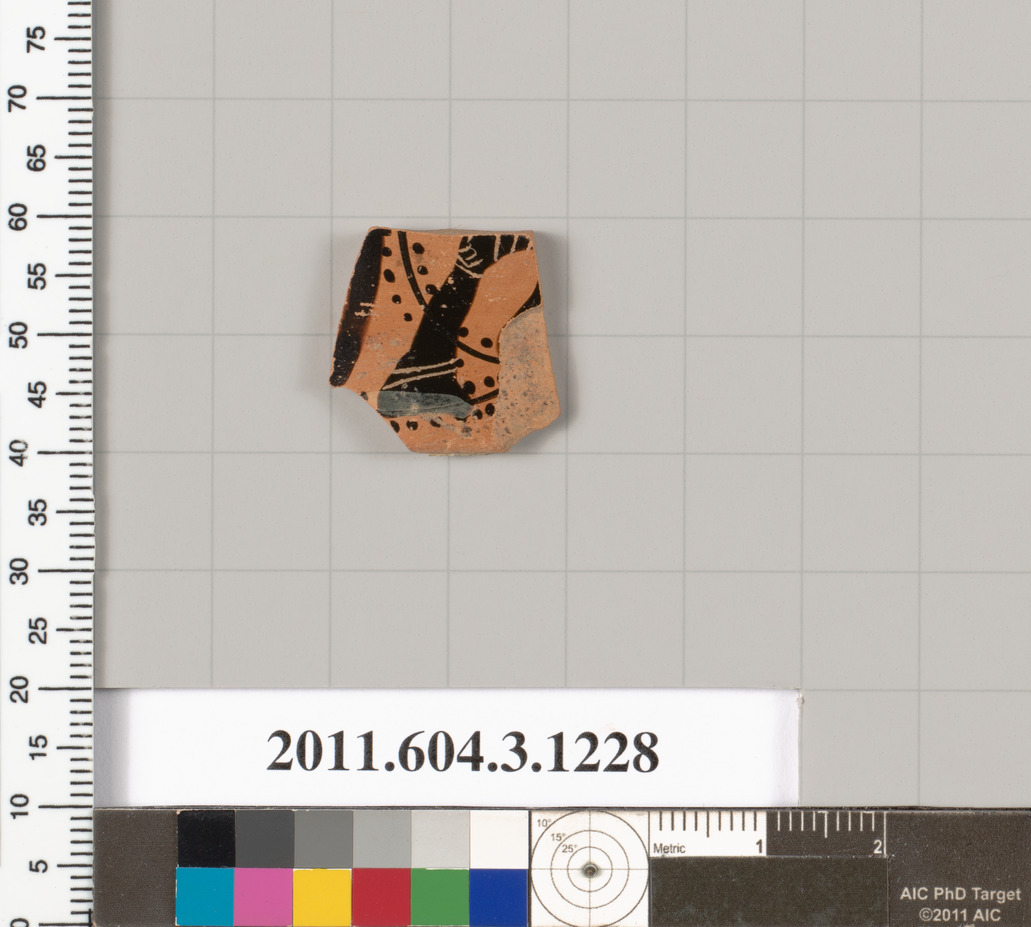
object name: kyathos fragment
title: Terracotta rim fragment of a kyathos (cup-shaped ladle)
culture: greek, attic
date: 534-468 BCE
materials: terracotta